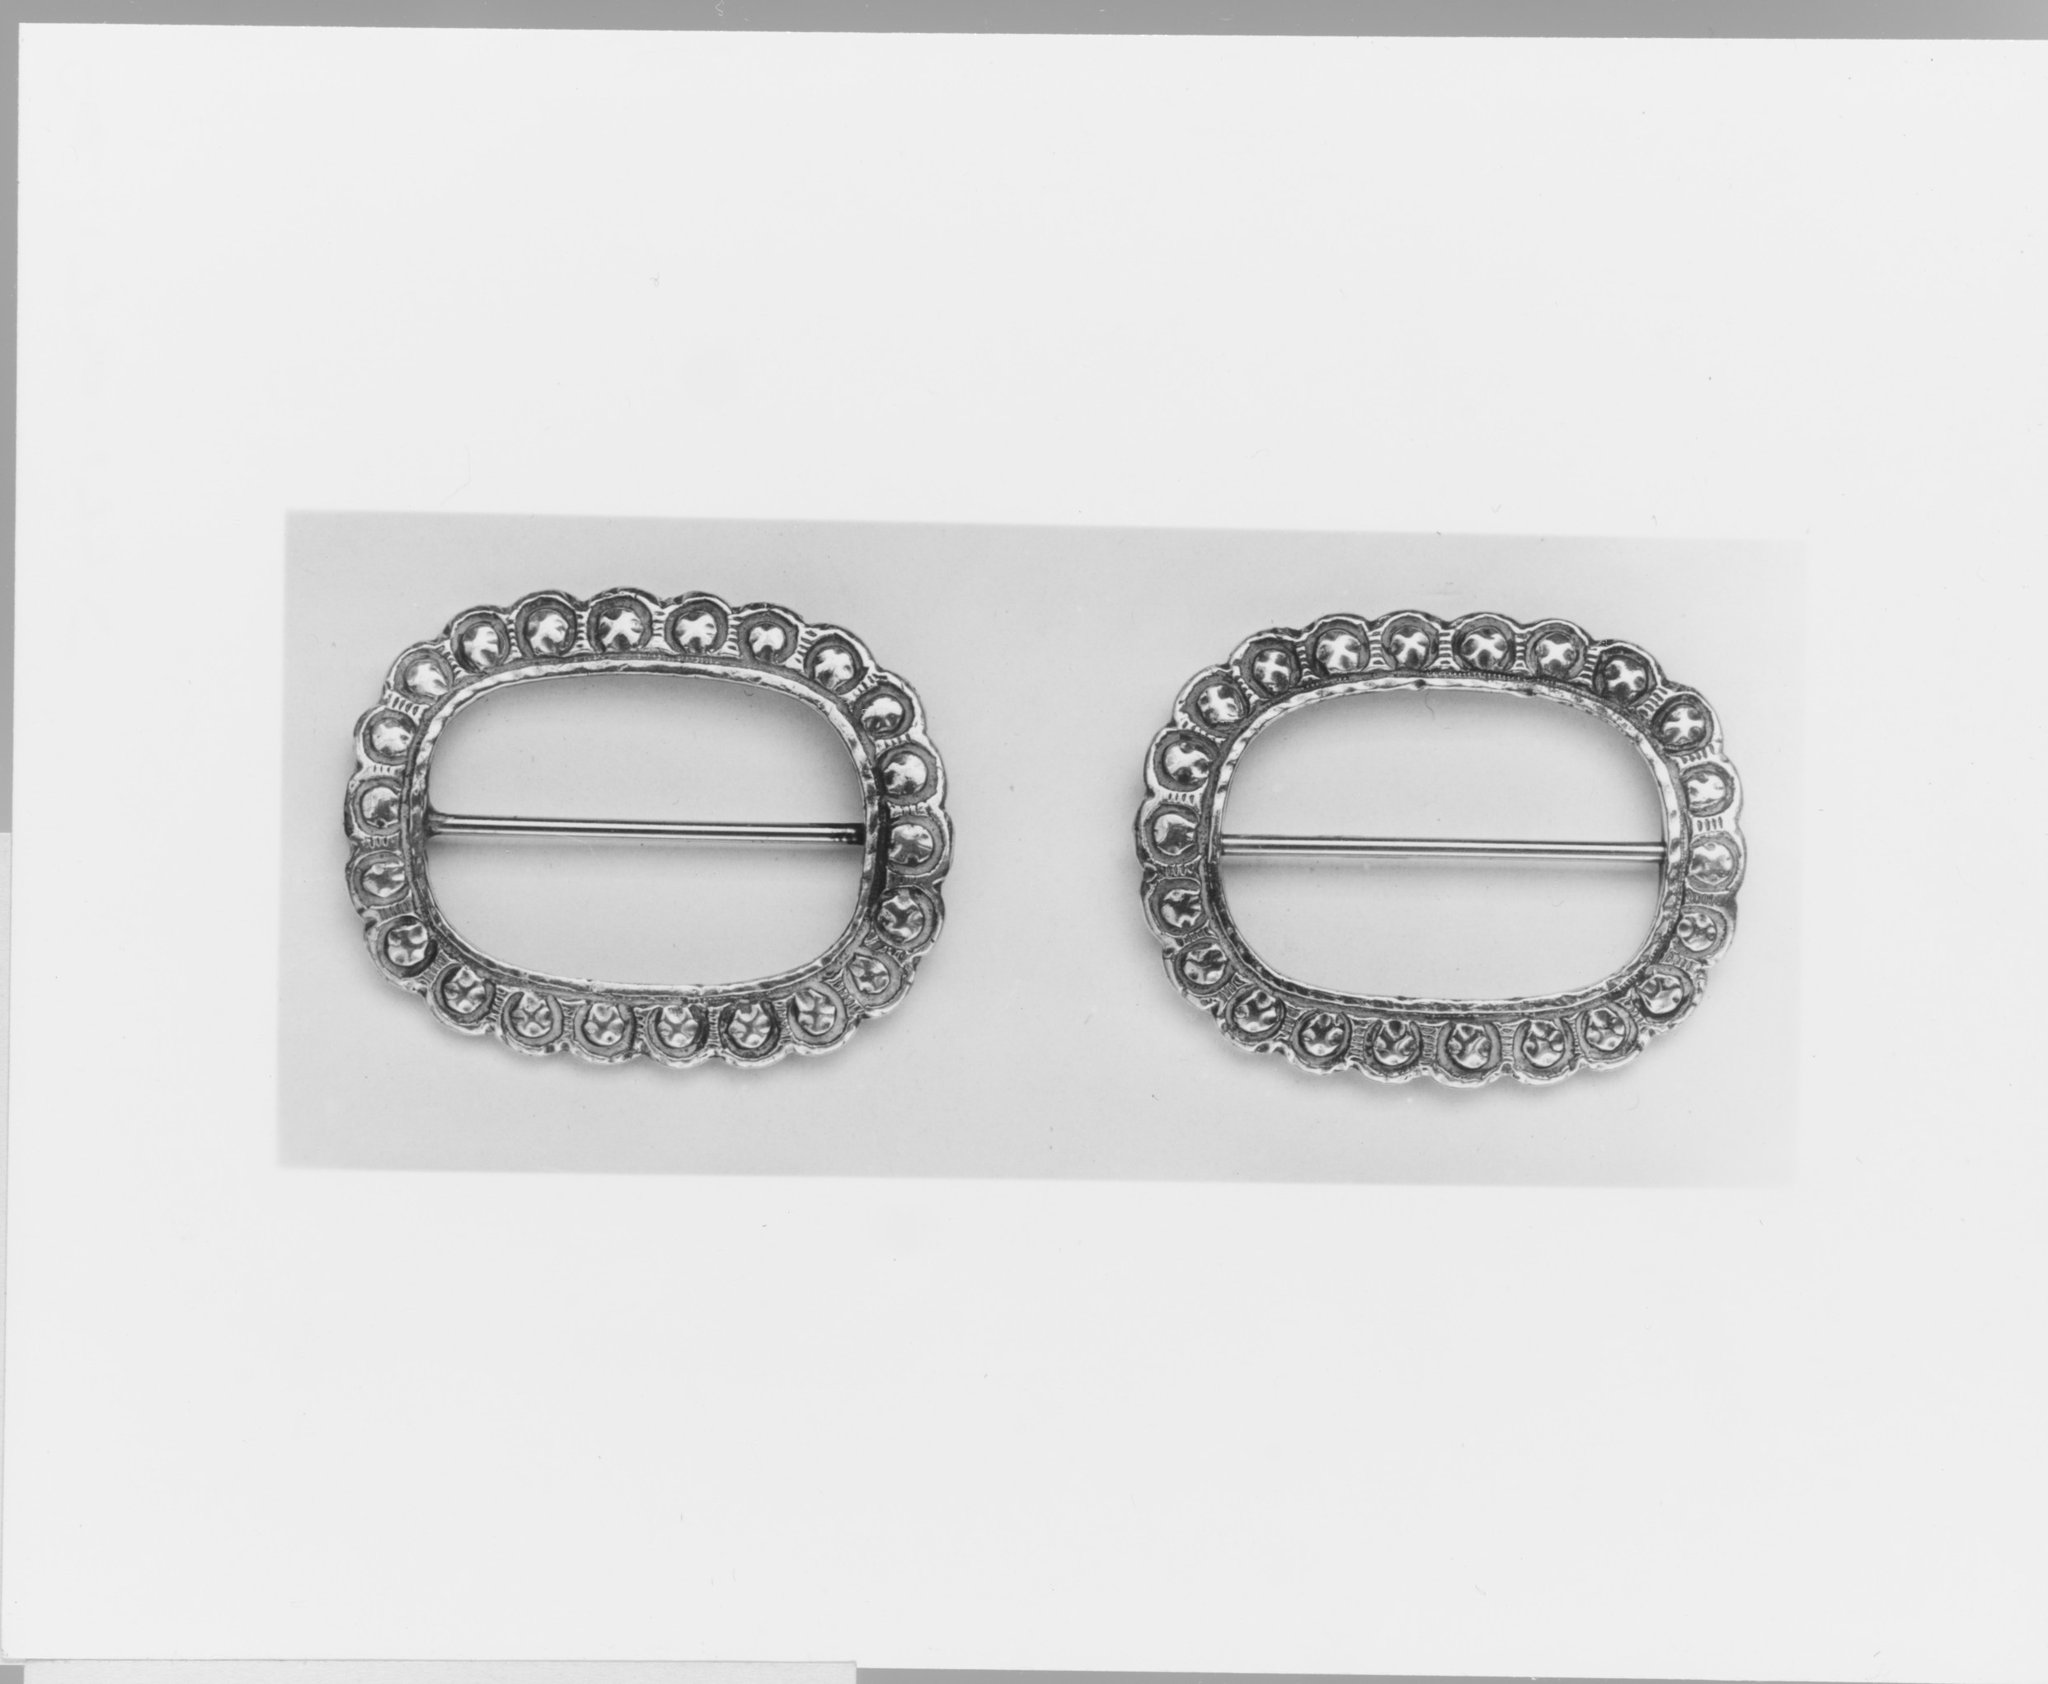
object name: buckle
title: Knee Buckle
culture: american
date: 1730-1775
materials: silver